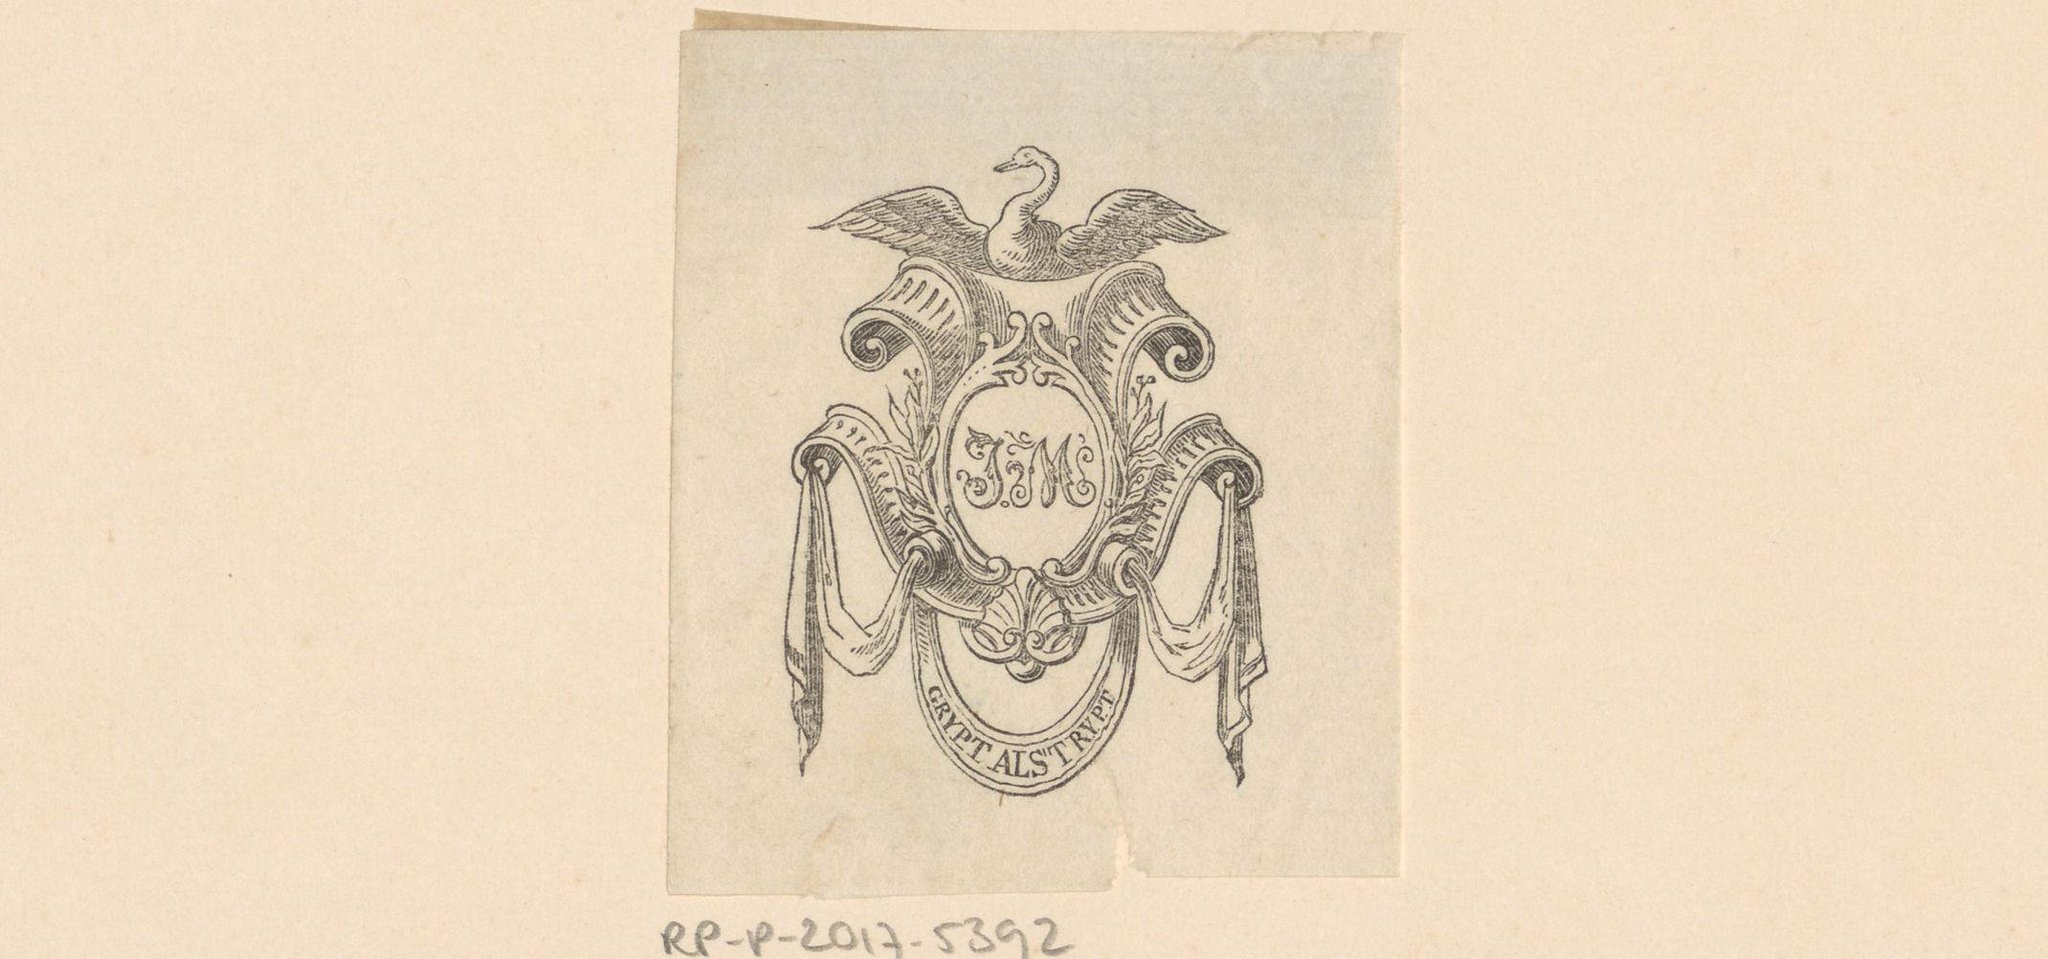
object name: bookplate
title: Ex libris van Isaak Meulman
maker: Anonymous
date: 1817-1868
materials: paper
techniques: printing block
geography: netherlands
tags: water-birds: swan, armorial bearing, heraldry